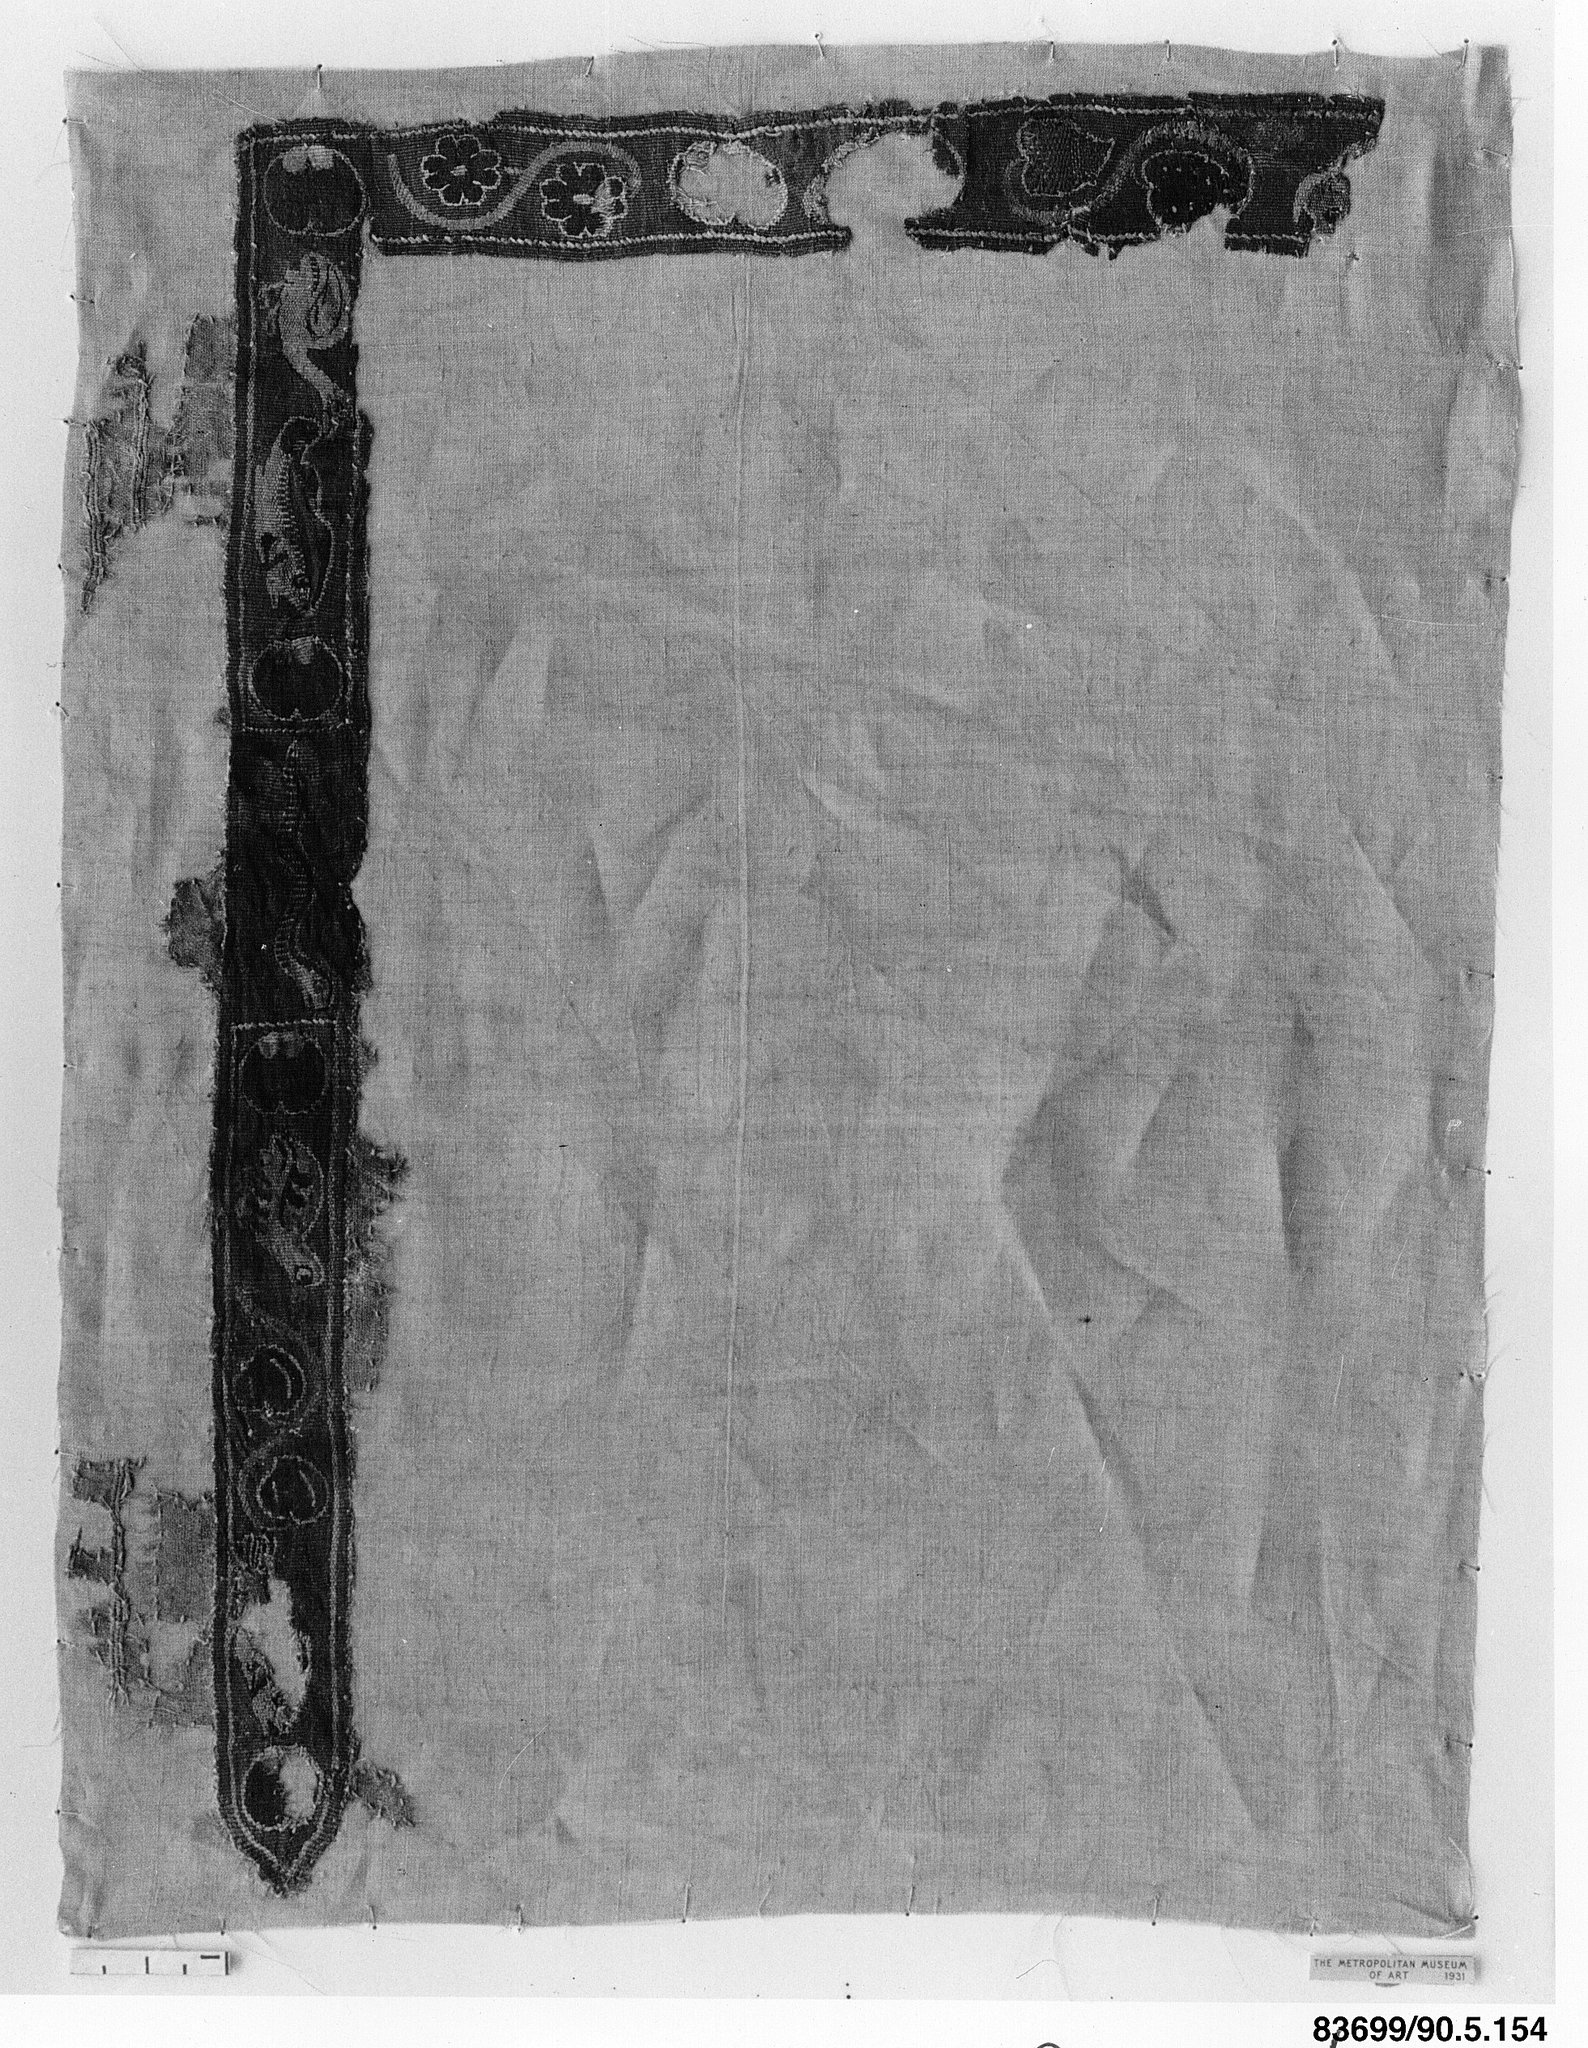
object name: textile fragment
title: Ornamental Band with Nilotic Elements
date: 501-700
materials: linen, wool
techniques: weave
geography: egypt